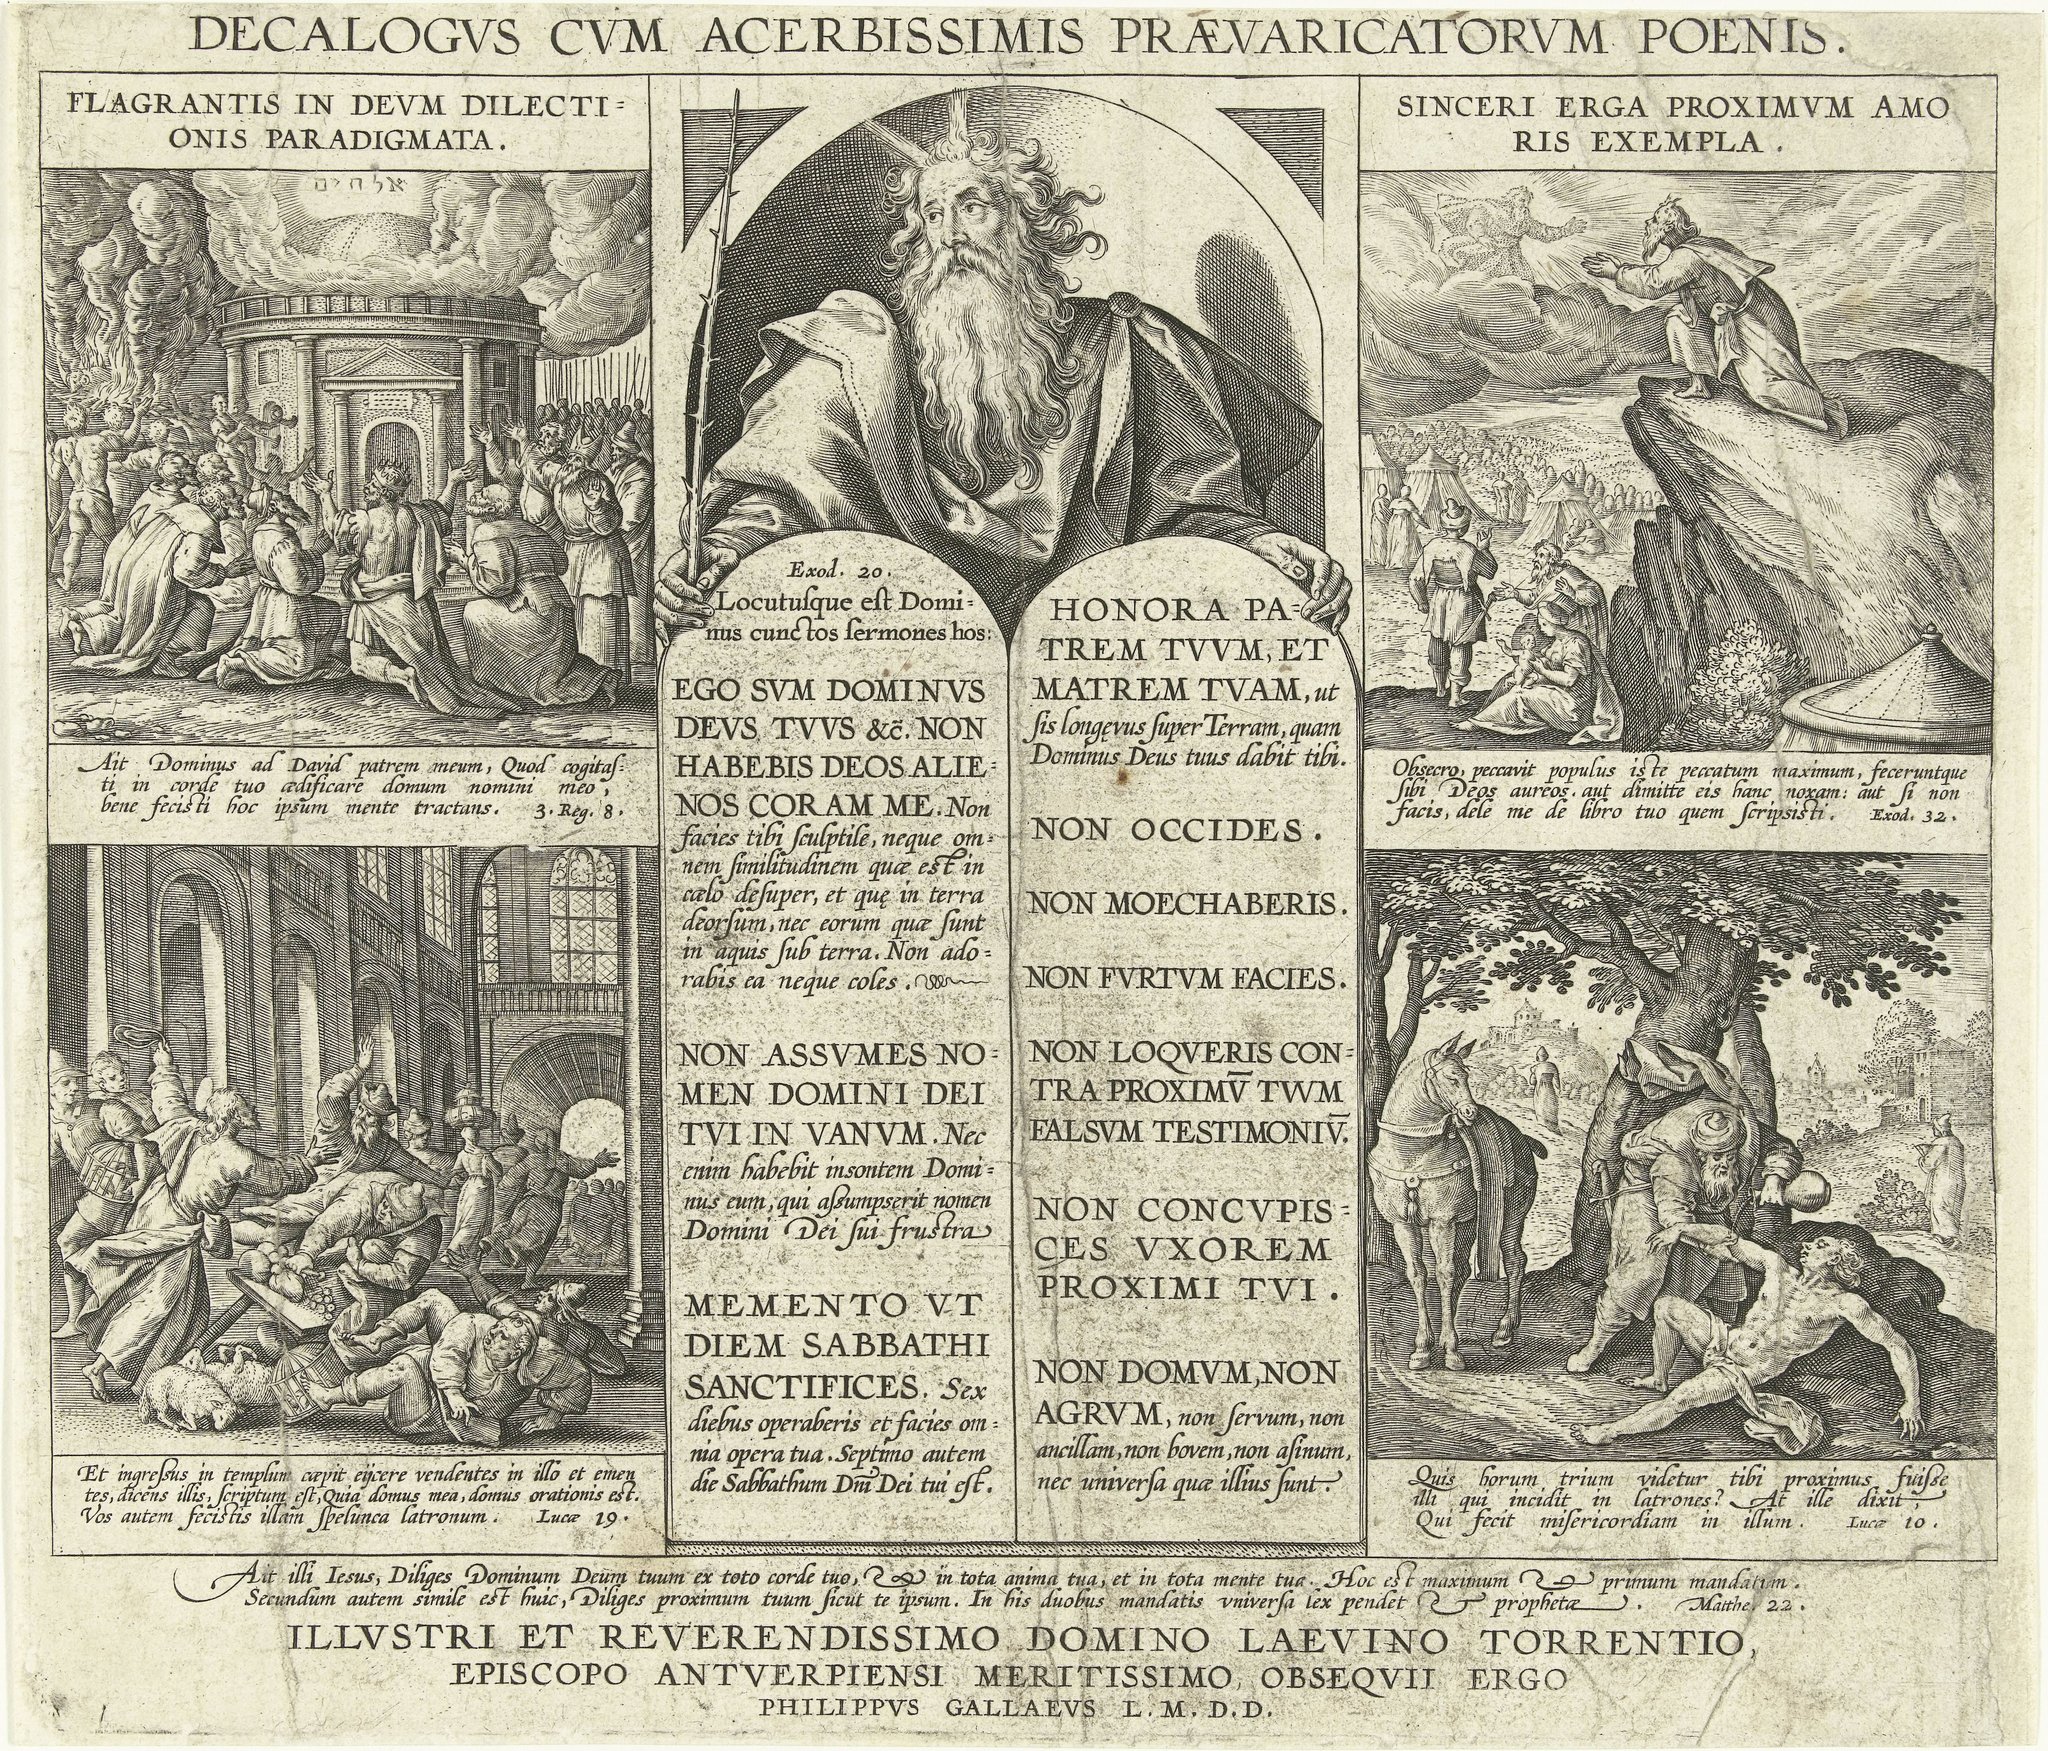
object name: titelprent, frontispice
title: Mozes met de Tien Geboden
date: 1585-1589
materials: paper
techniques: engraving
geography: antwerp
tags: purification of the temple ('first' and 'second'): christ driving the money-changers from the temple with a whip (matthew 21:12-13; mark 11:15-17; luke 19:45-46; john 12:12-19), prayer of solomon; solomon kneels before the altar, moses (not in biblical context); possible attributes: rays of light or horns on his head, rod, tables of the law, a samaritan tending the wounds of the traveller, the ten commandments (exodus 20:3-17), moses on mount sinai with the tables of the law (exodus 24:9-18, 31:18)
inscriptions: collector's mark: Lugt 2228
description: Mozes staat in het midden en houdt twee stenen tafelen vast met daarop de Latijnse versie van de Tien Geboden. Aan weerszijden van hem vier afbeeldingen. Bovenaan links koning Salomo's gebed tijdens de inwijding van de tempel (1 Koningen 8). Onderaan links verdrijft Christus de geldwisselaars uit de tempel (Lucas 19:45). Bovenaan rechts de verschijning van God aan Mozes op de berg Sinaï (Exodus 19). Onderaan rechts een scène uit de parabel van de Barmhartige Samaritaan (Lucas 10:25-37). Deze afbeeldingen hebben een Latijns onderschrift. De prent heeft een Latijns boven- en onderschrift. De prent is de titelprent van een serie over de Tien Geboden uitgebeeld met behulp van scènes van het Oude Testament.